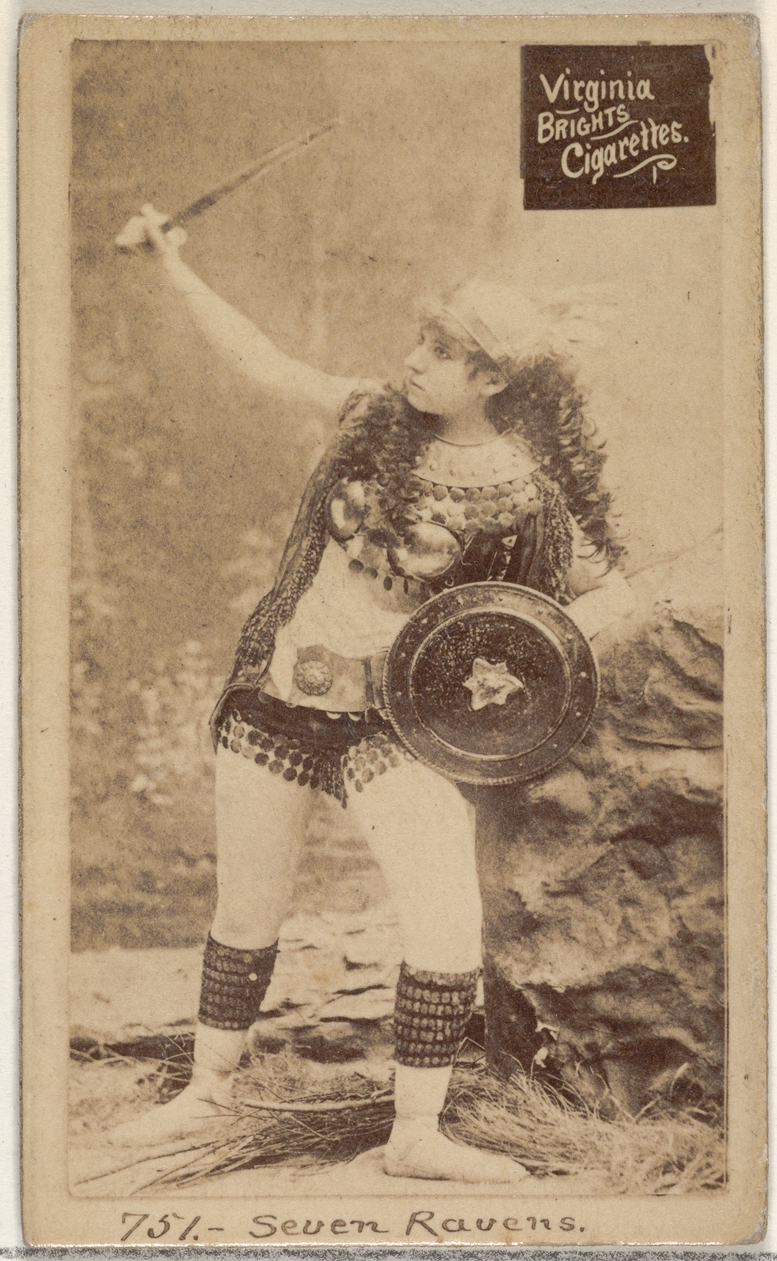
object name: photograph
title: Card 751, Seven Ravens, from the Actors and Actresses series (N45, Type 2) for Virginia Brights Cigarettes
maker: allen & ginter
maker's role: publisher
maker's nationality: american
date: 1888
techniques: albumen silver print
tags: shields,portraits,women,actresses